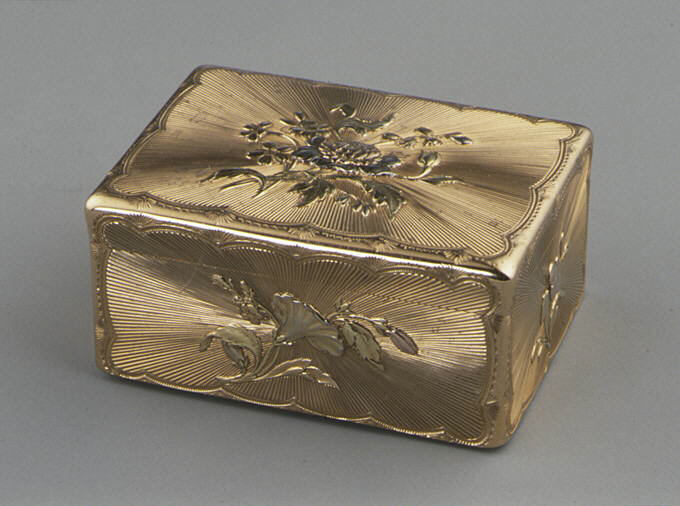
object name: snuffbox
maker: jean ducrollay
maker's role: maker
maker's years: 1709-1760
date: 1754-1755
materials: gold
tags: flowers